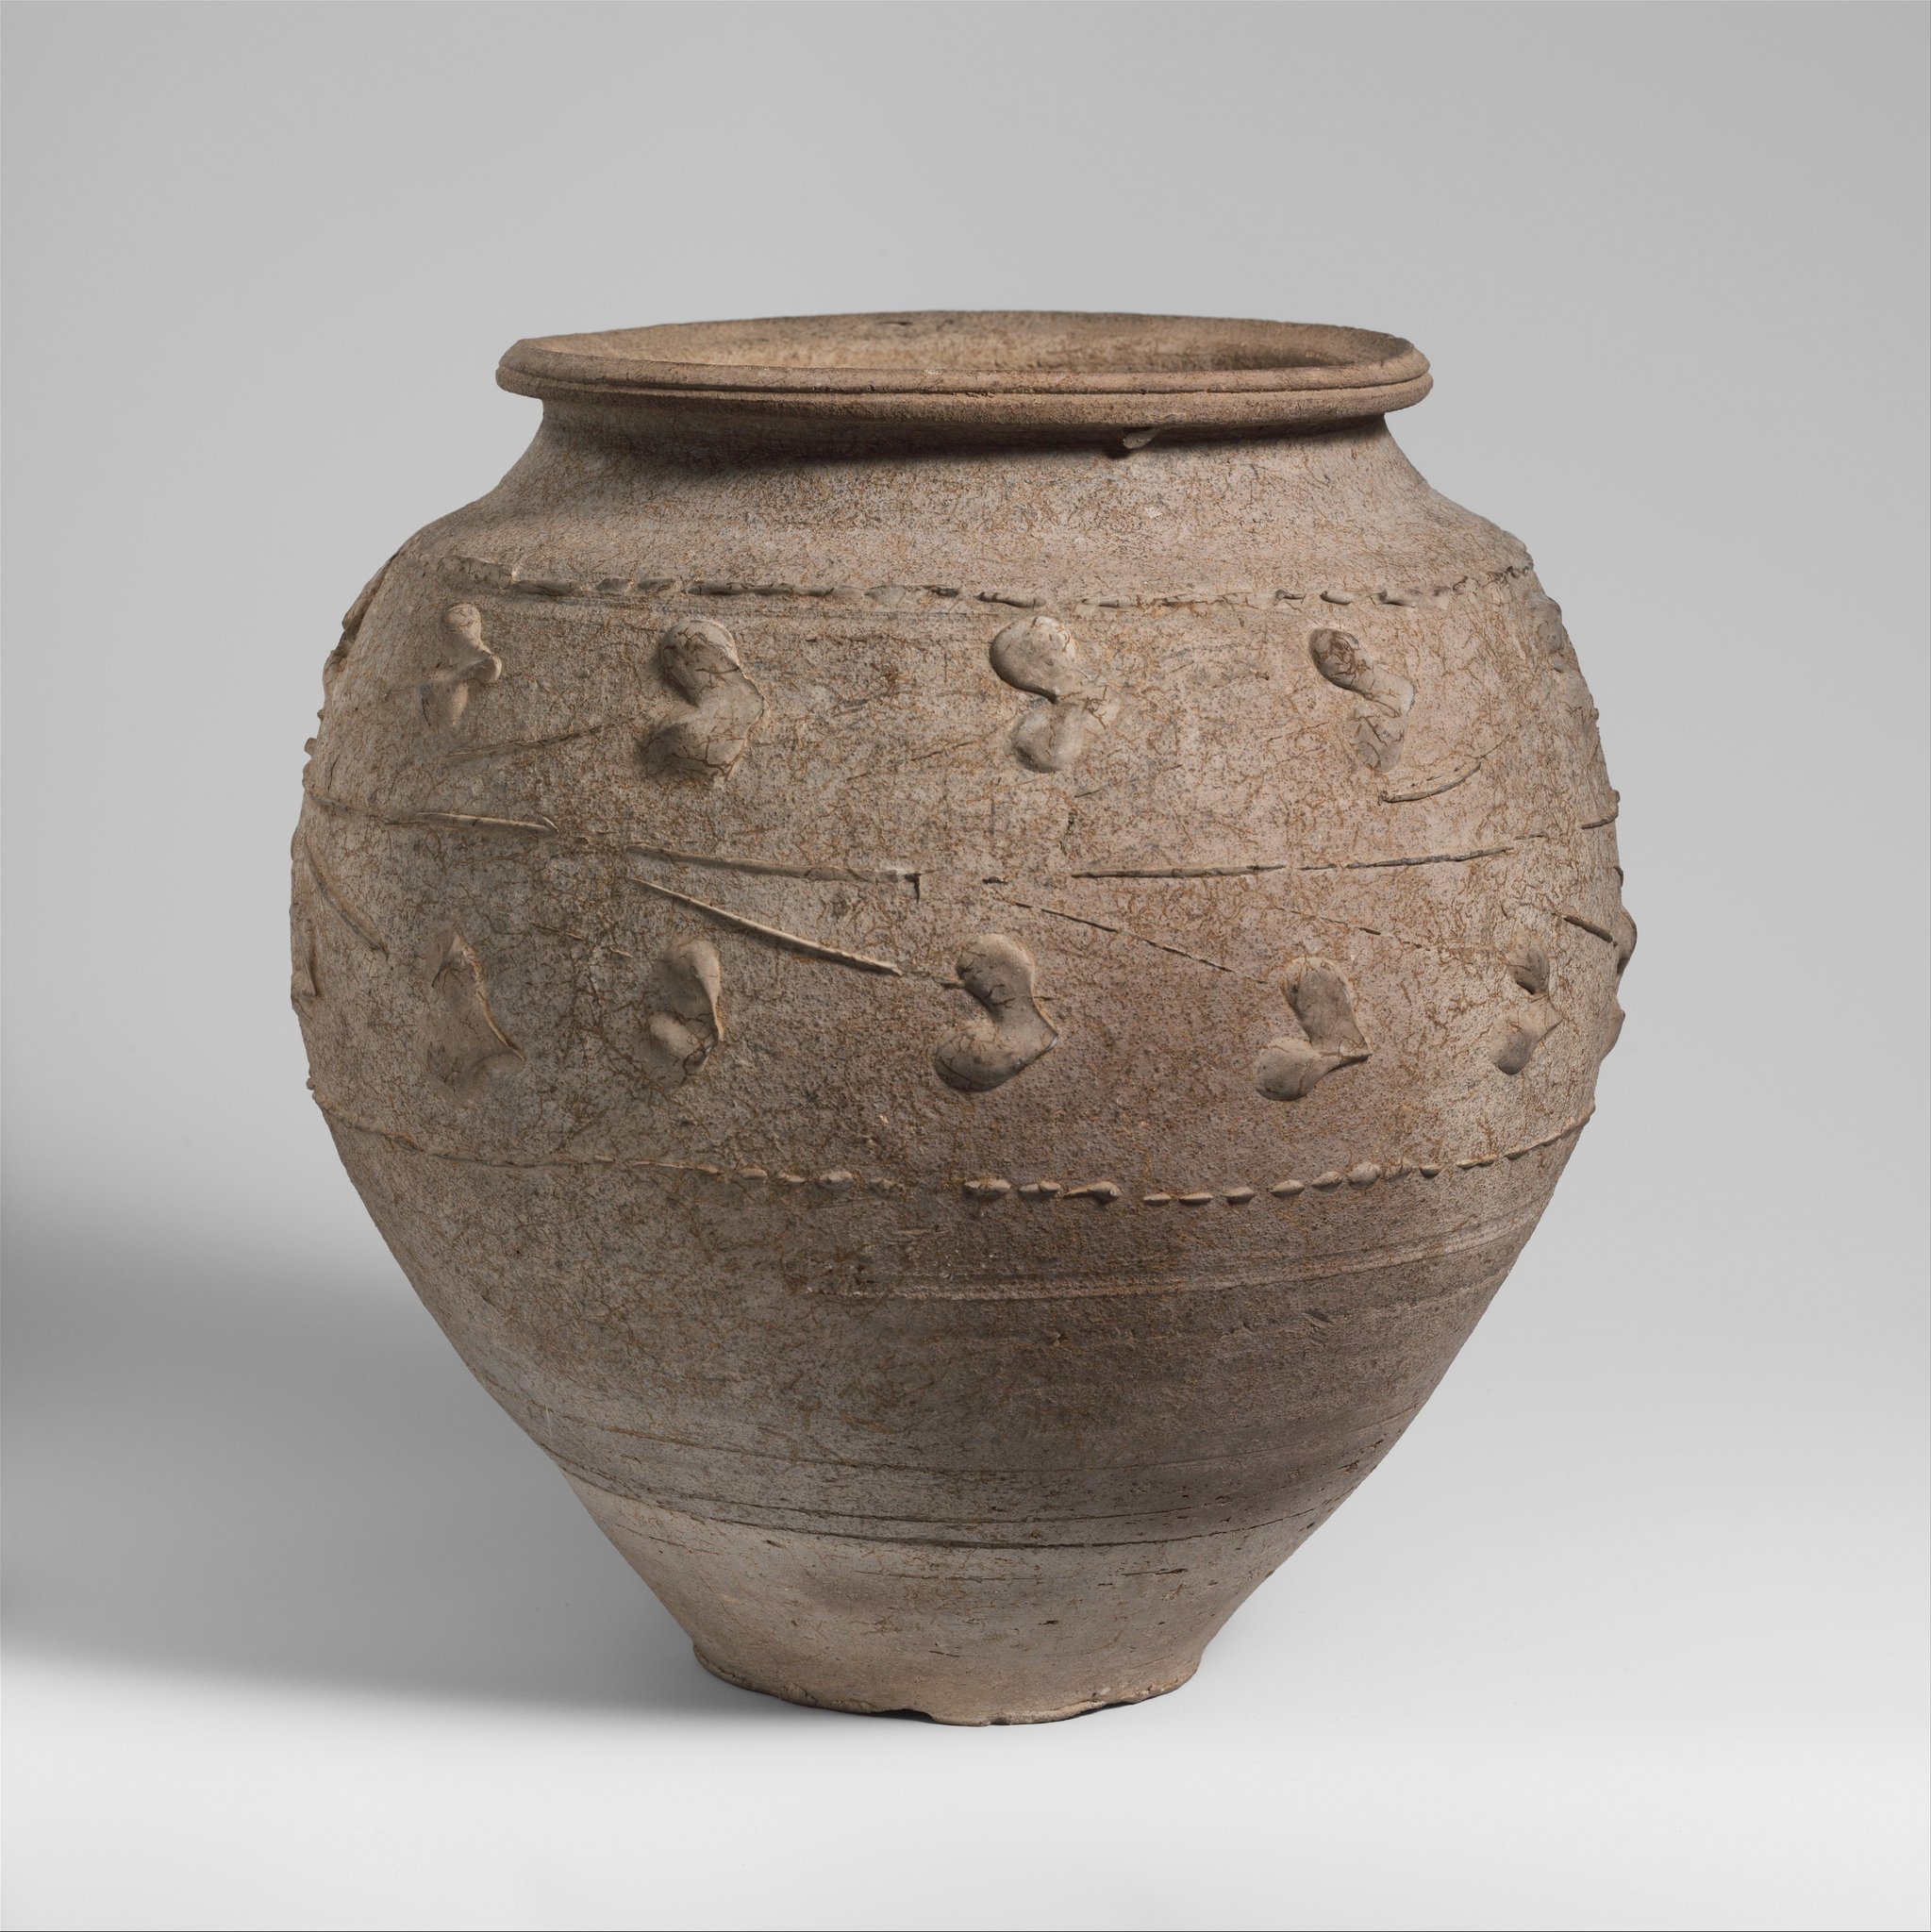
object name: urn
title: Terracotta jar with barbotine decoration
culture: roman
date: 101-300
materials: terracotta